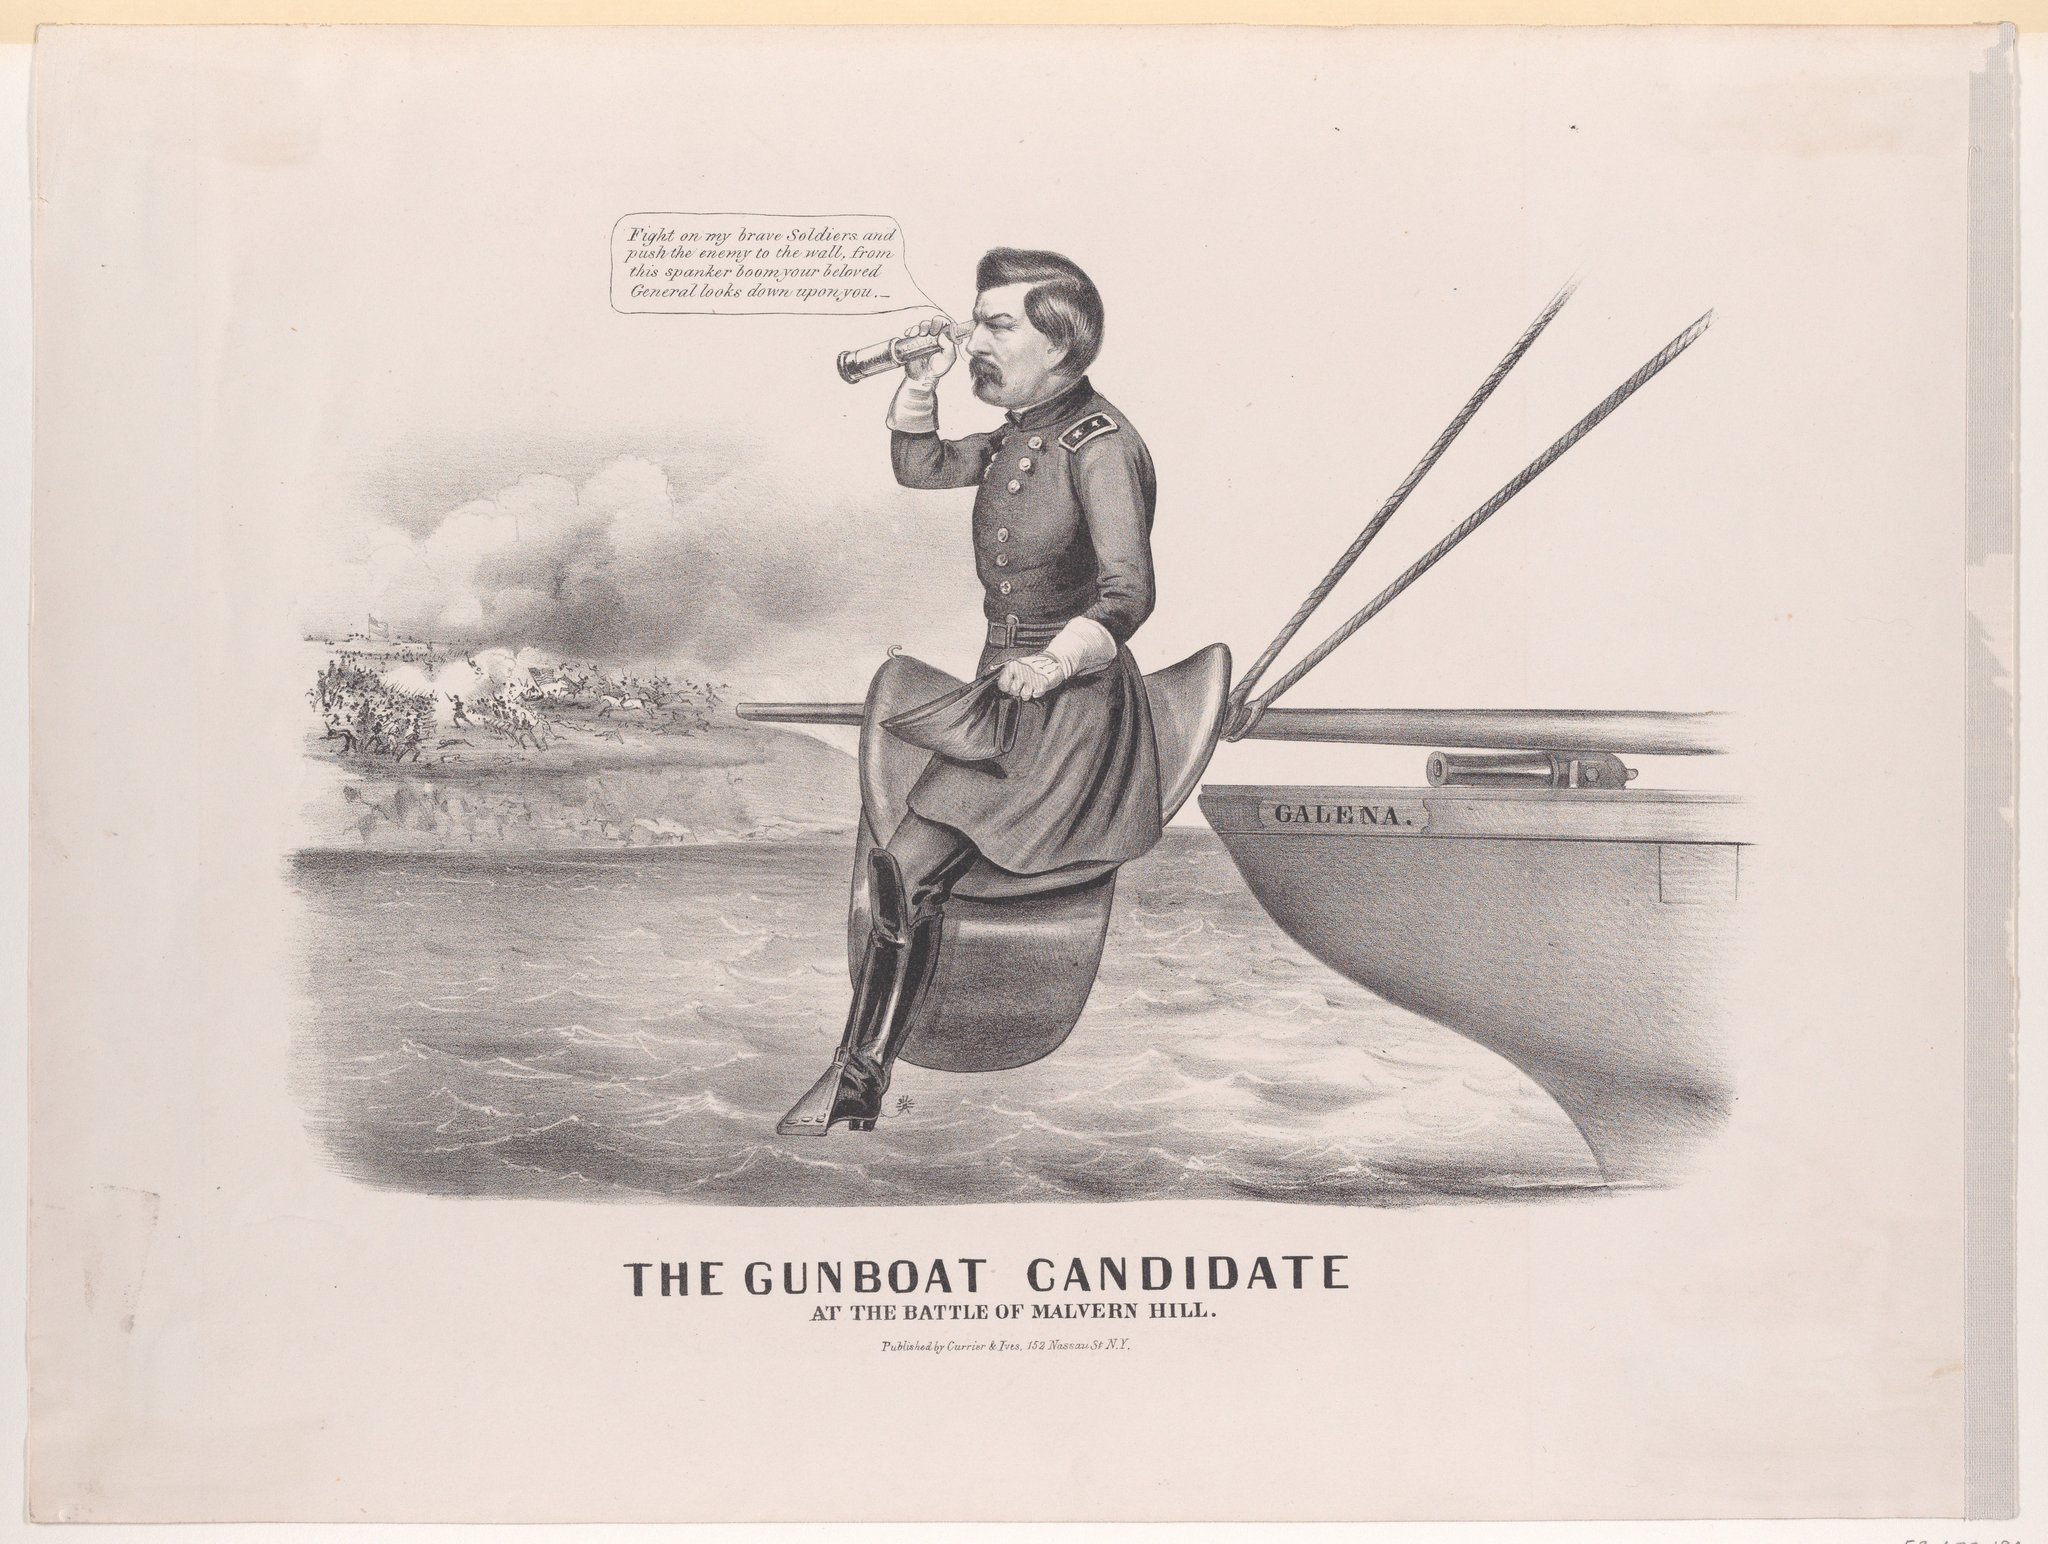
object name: print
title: The Gun Boat Candidate, At the Battle of Malvern Hill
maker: louis maurer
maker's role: artist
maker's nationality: american, born germany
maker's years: 1832-1932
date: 1862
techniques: lithograph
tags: satire,american civil war,men,generals,politics